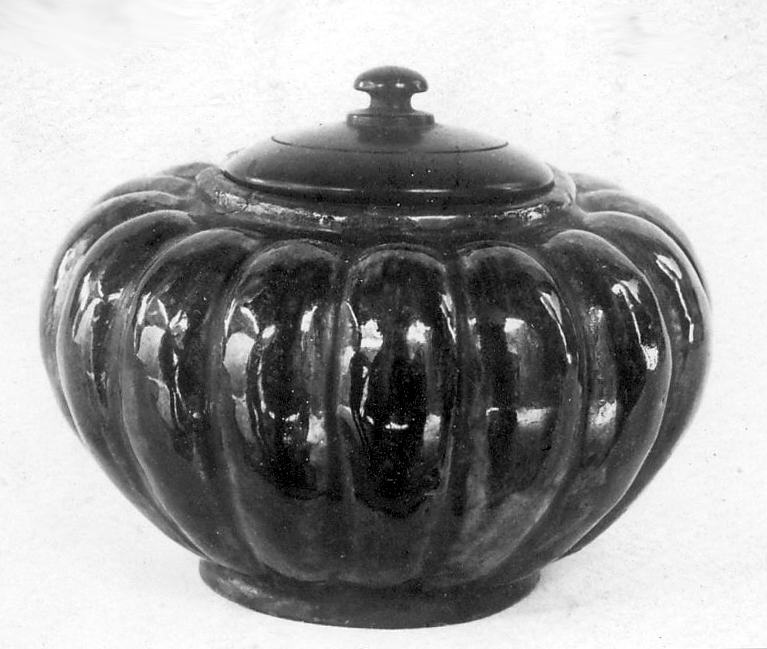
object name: tea jar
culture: japanese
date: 1801-1900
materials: clay, glaze